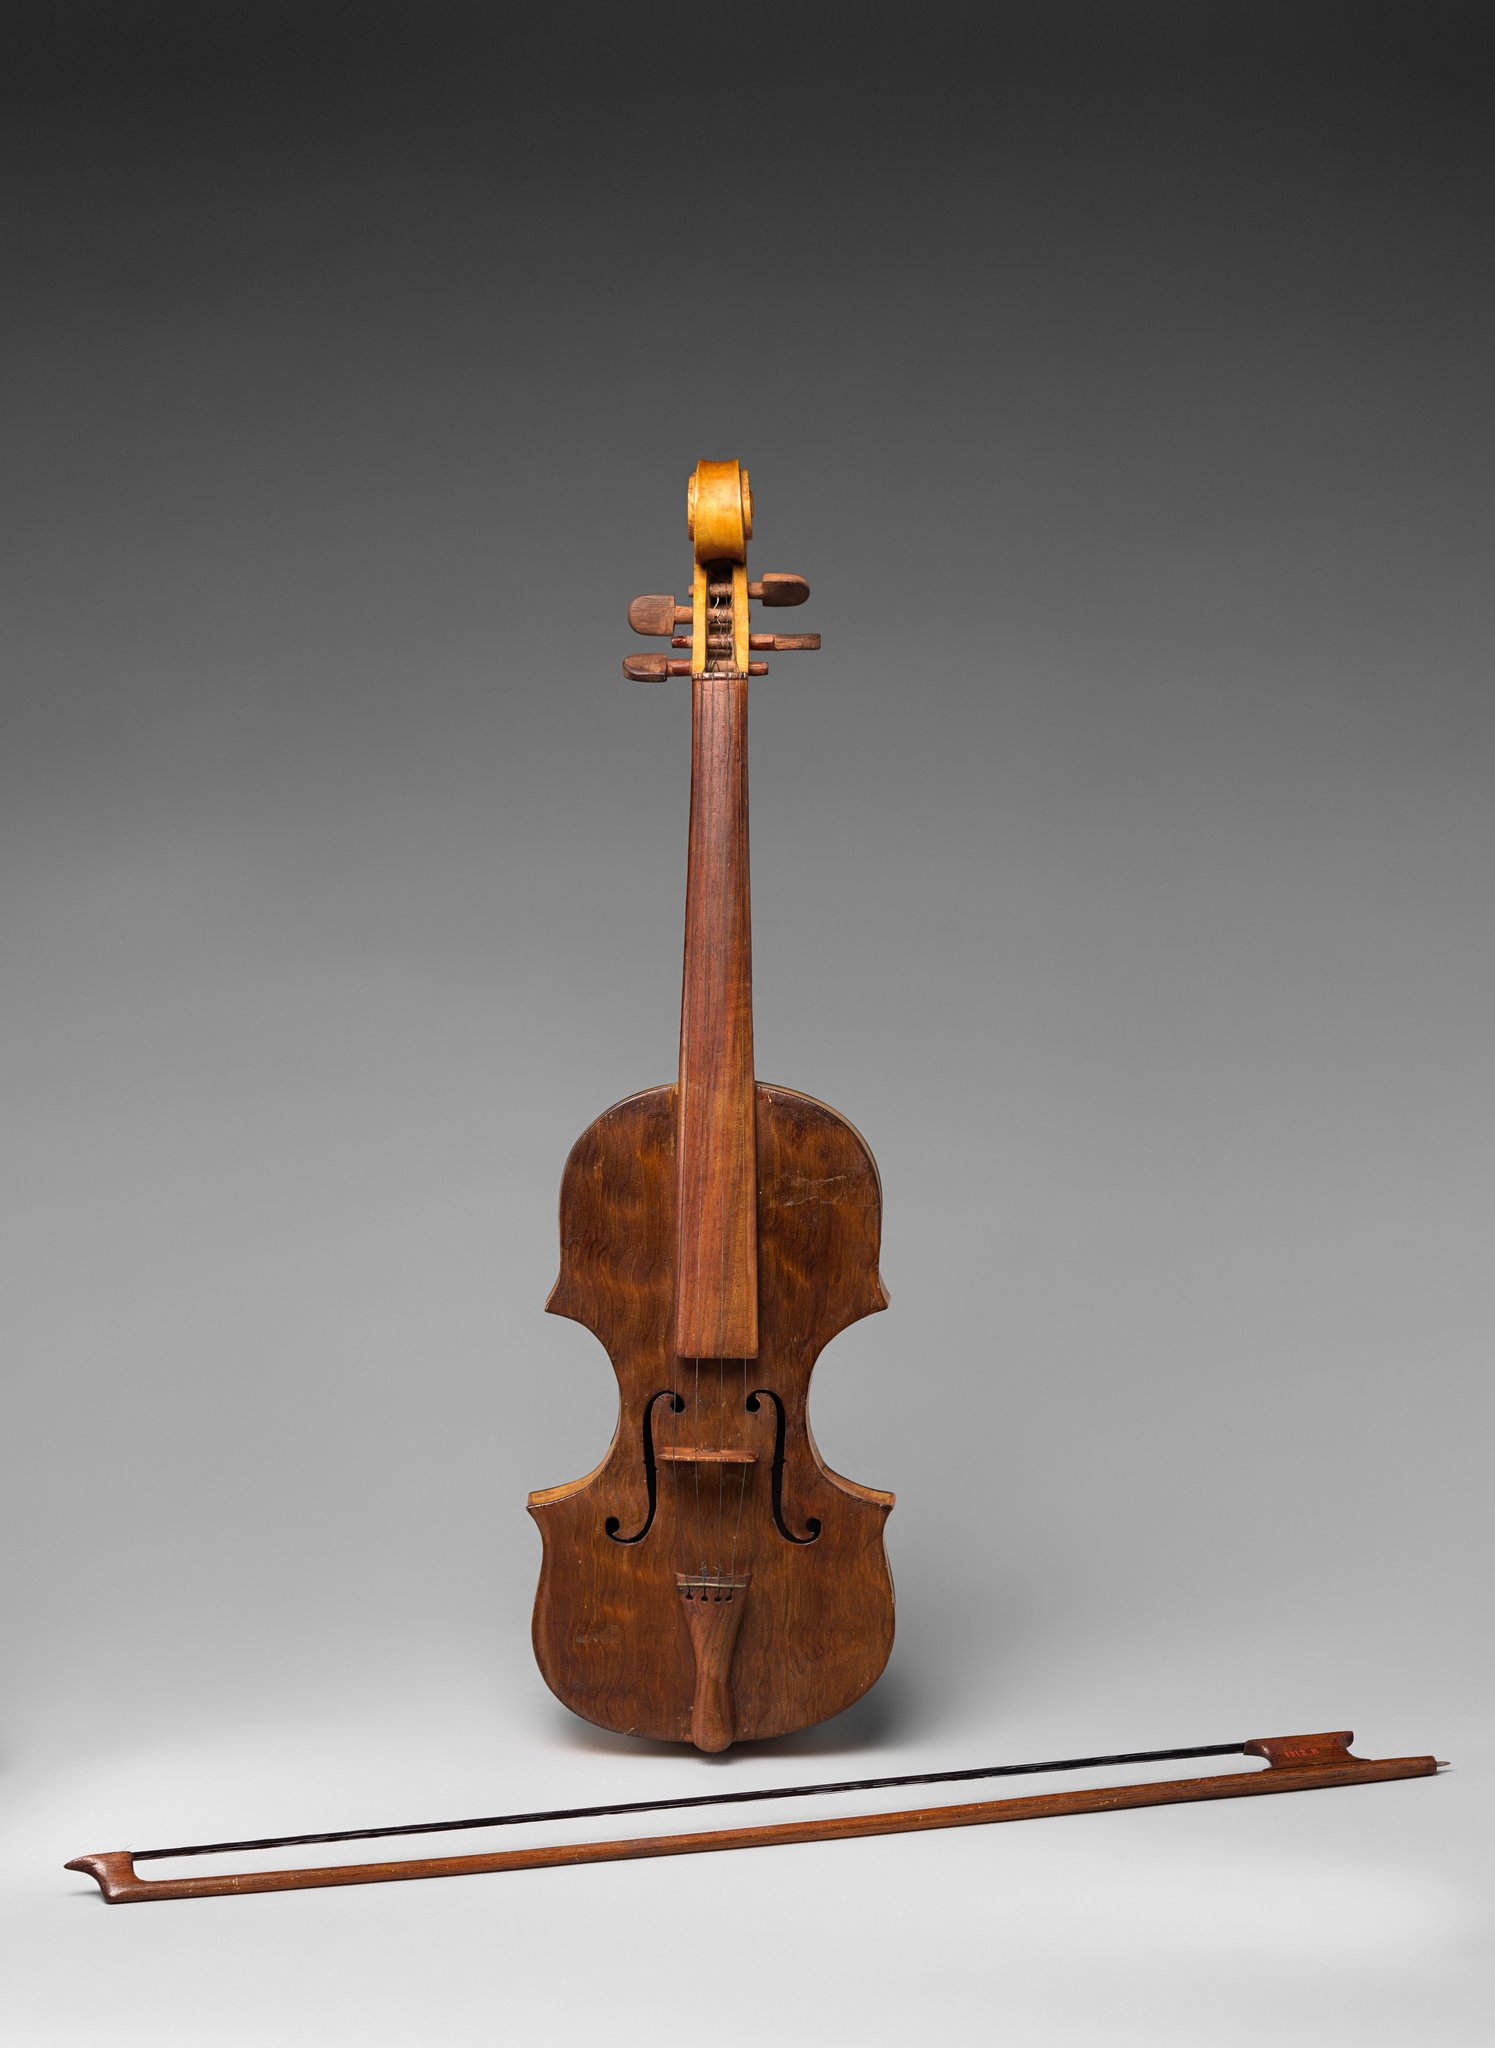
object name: fiddle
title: Violin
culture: american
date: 1801-1900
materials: wood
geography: united states